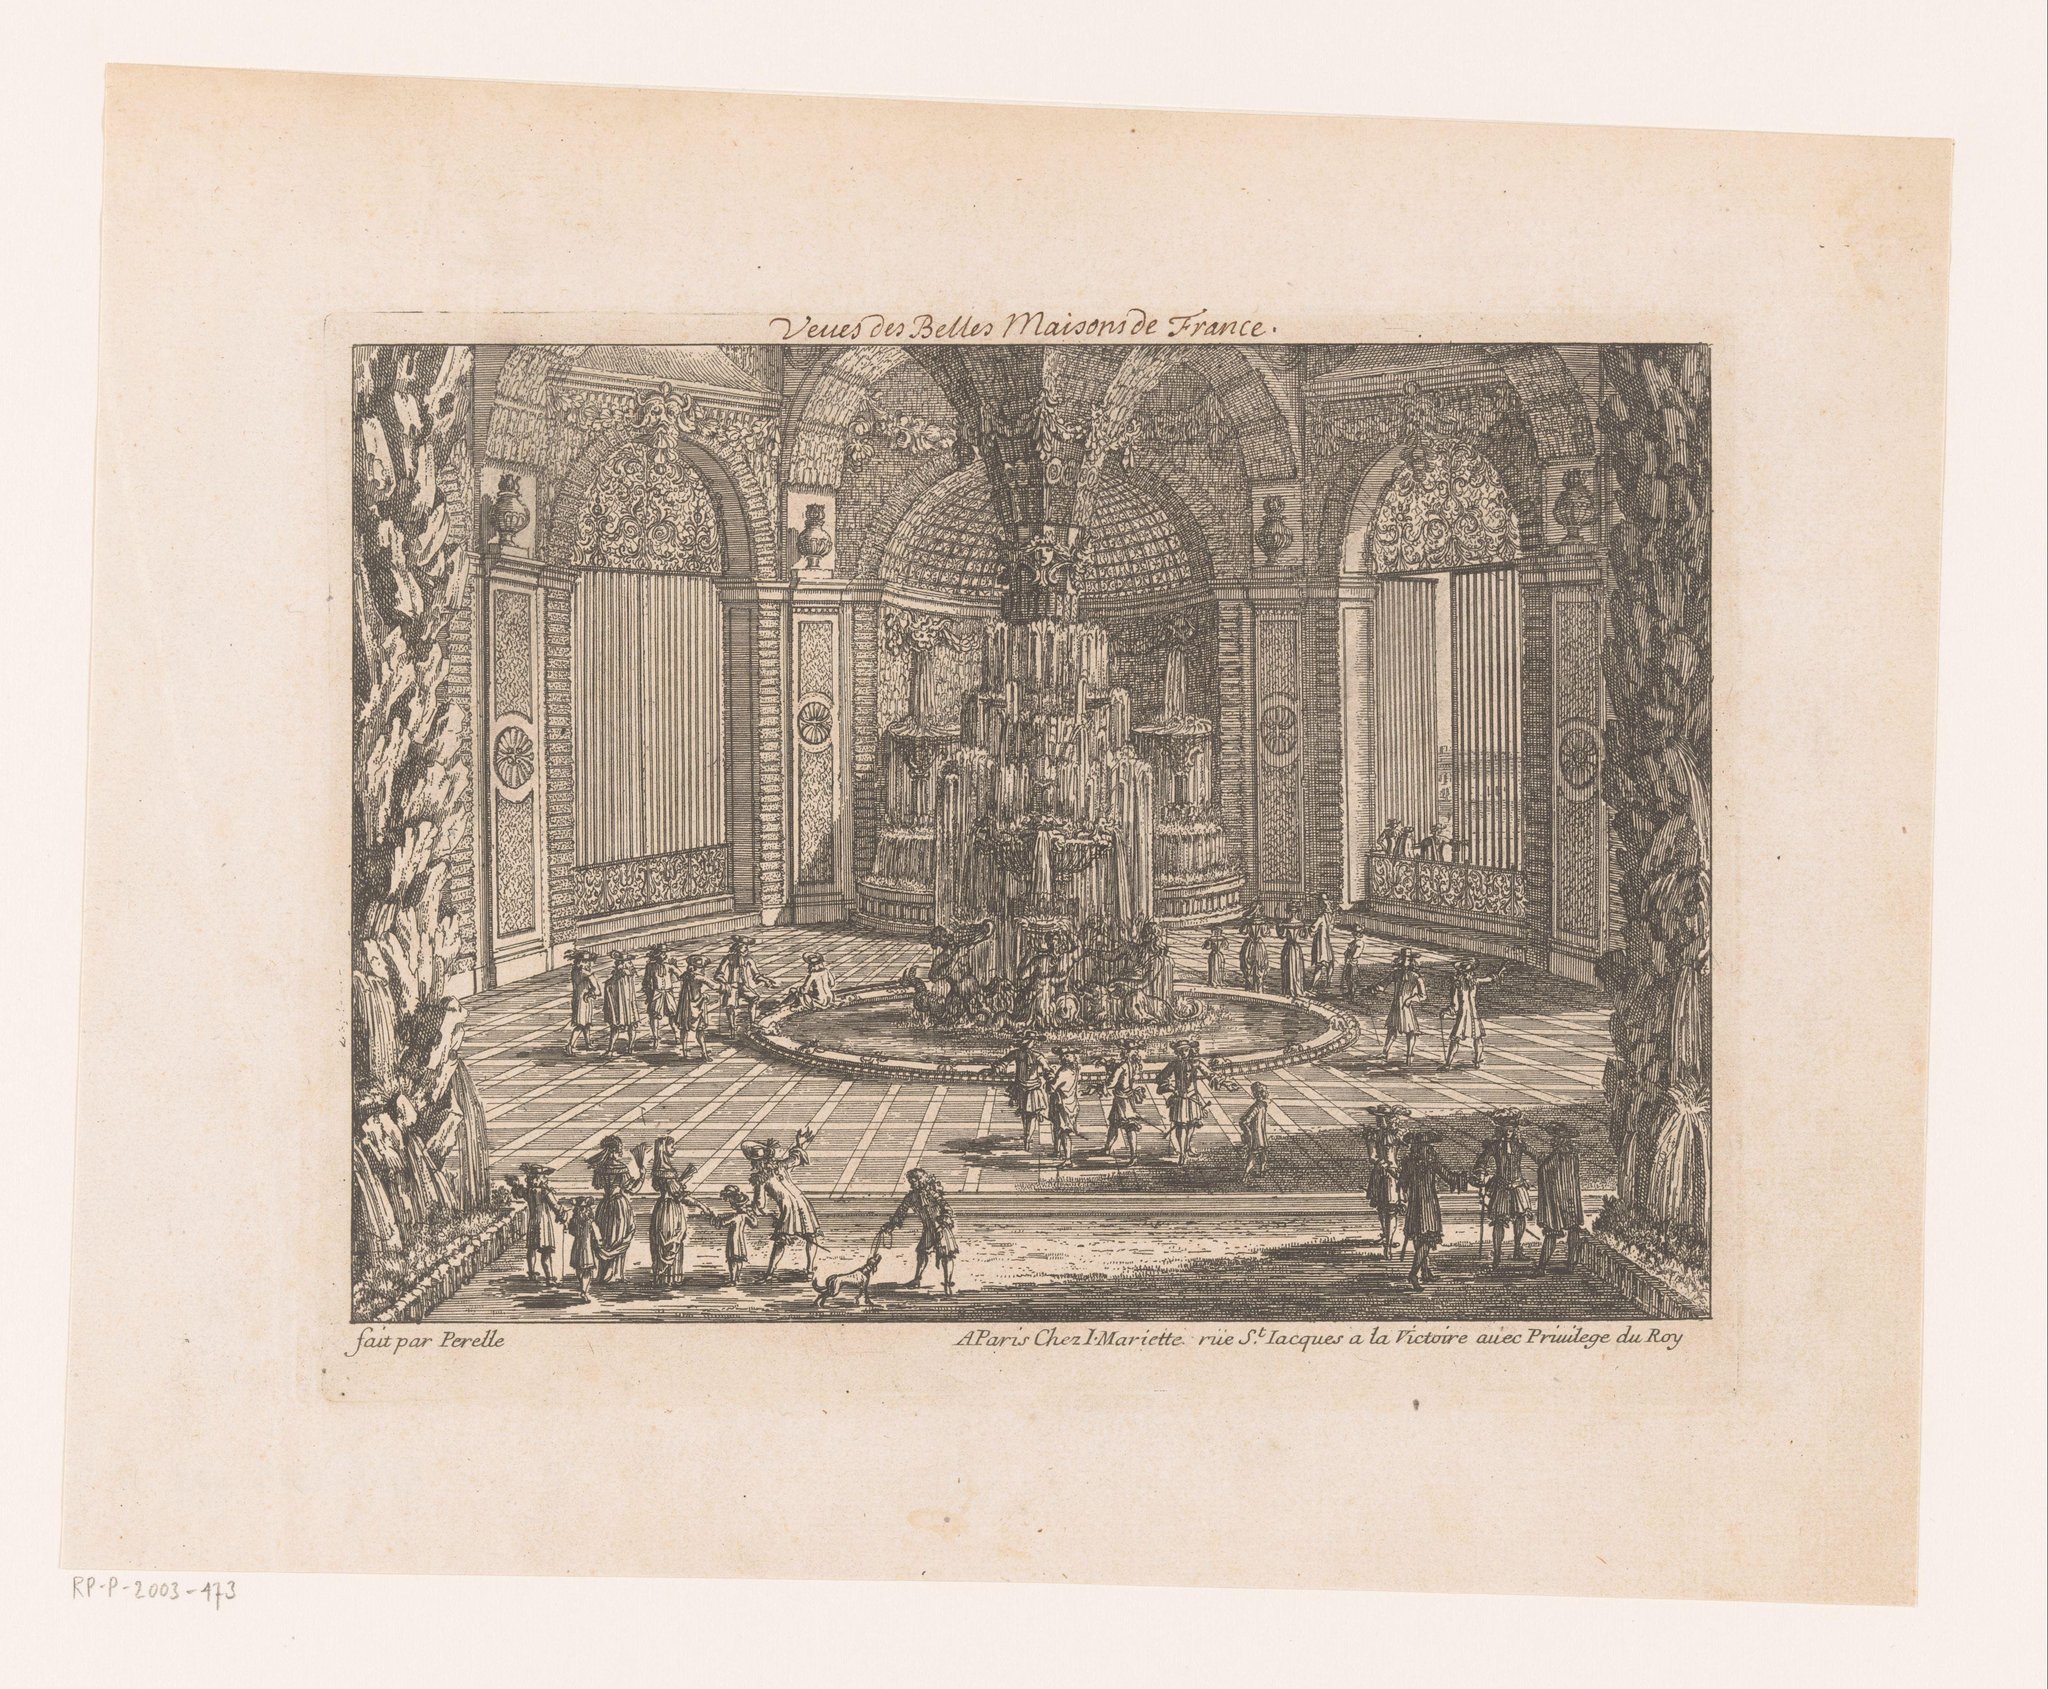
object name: titelprent, frontispice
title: Titelprent met figuren bij fontein in zaal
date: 1670-1677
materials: paper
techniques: etching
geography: paris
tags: ornamental fountain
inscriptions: annotation: ‘Veues des Belles Maisons de France.’, collector's mark: Lugt 2228